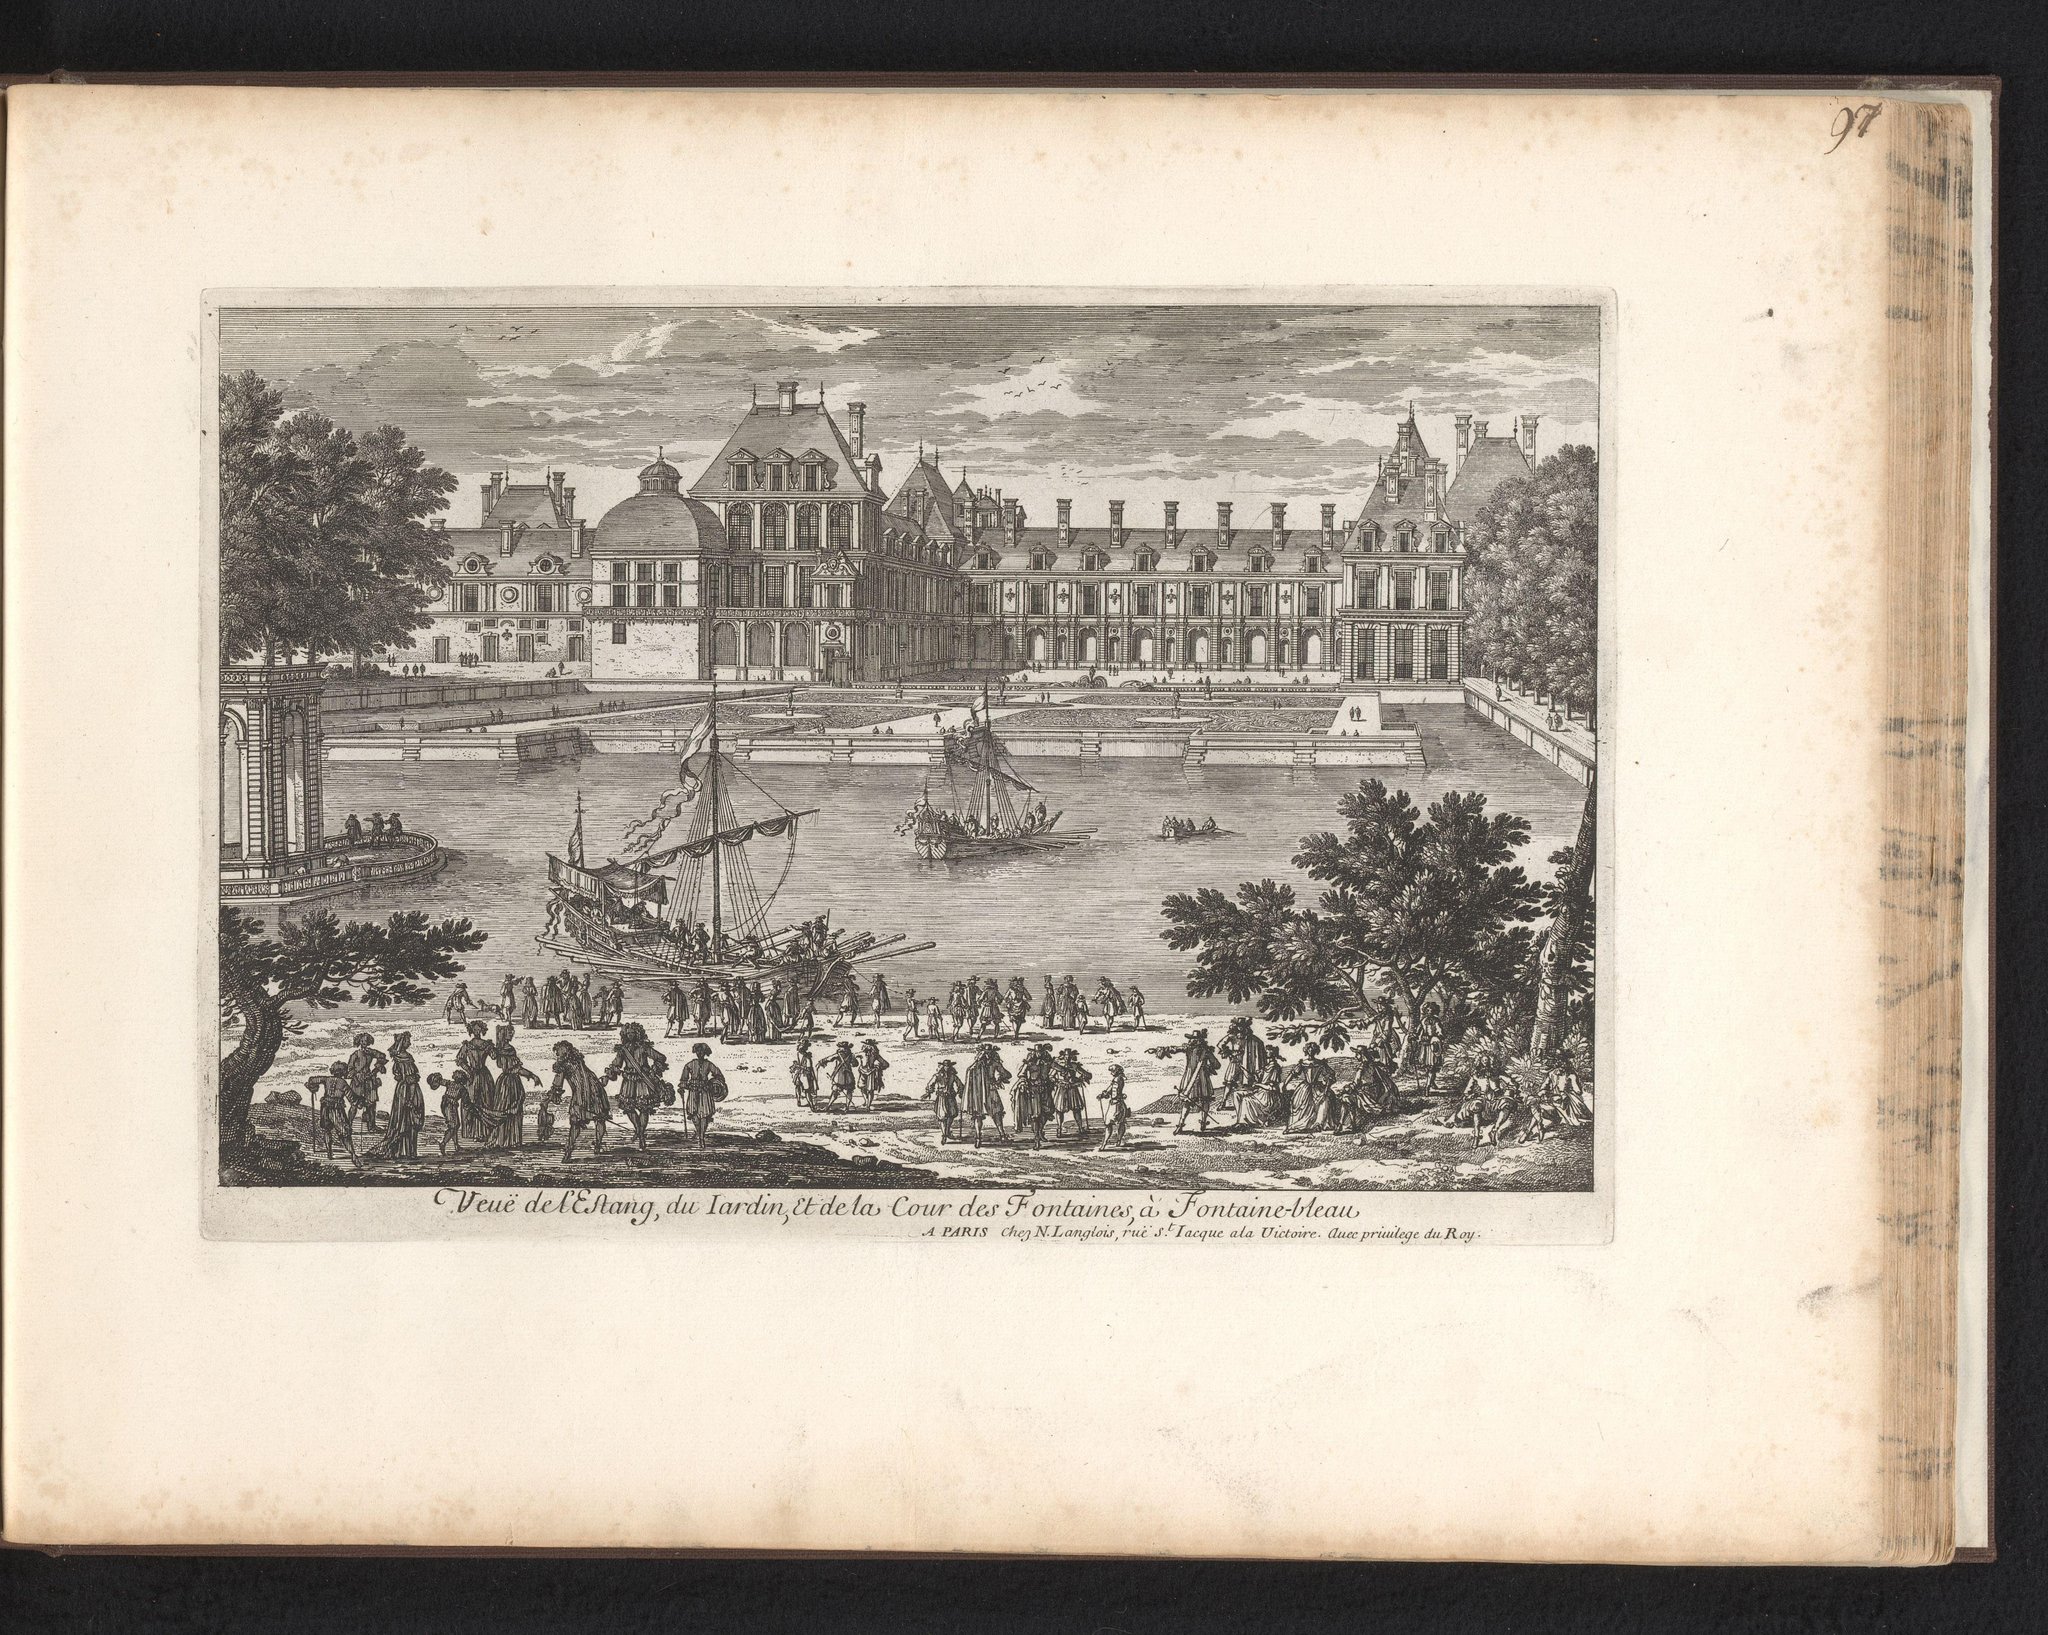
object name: album leaf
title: Recueil de vues de monuments de Paris, des principales résidences royales et des principaux châteaux de France et de Rome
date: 1660-1703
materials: paper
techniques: etching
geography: france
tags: french or architectonic garden; formal garden, landscape with tower or castle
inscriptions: collector's mark: Lugt 2228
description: Prenten met het signatuur 'Perelle' kunnen zowel door vader Gabriel als door zonen Nicolas en Adam gemaakt zijn. De uitgevers vader en zoon Nicolas Langlois worden allebei vermeld als N. Langlois op hetzelfde adres.